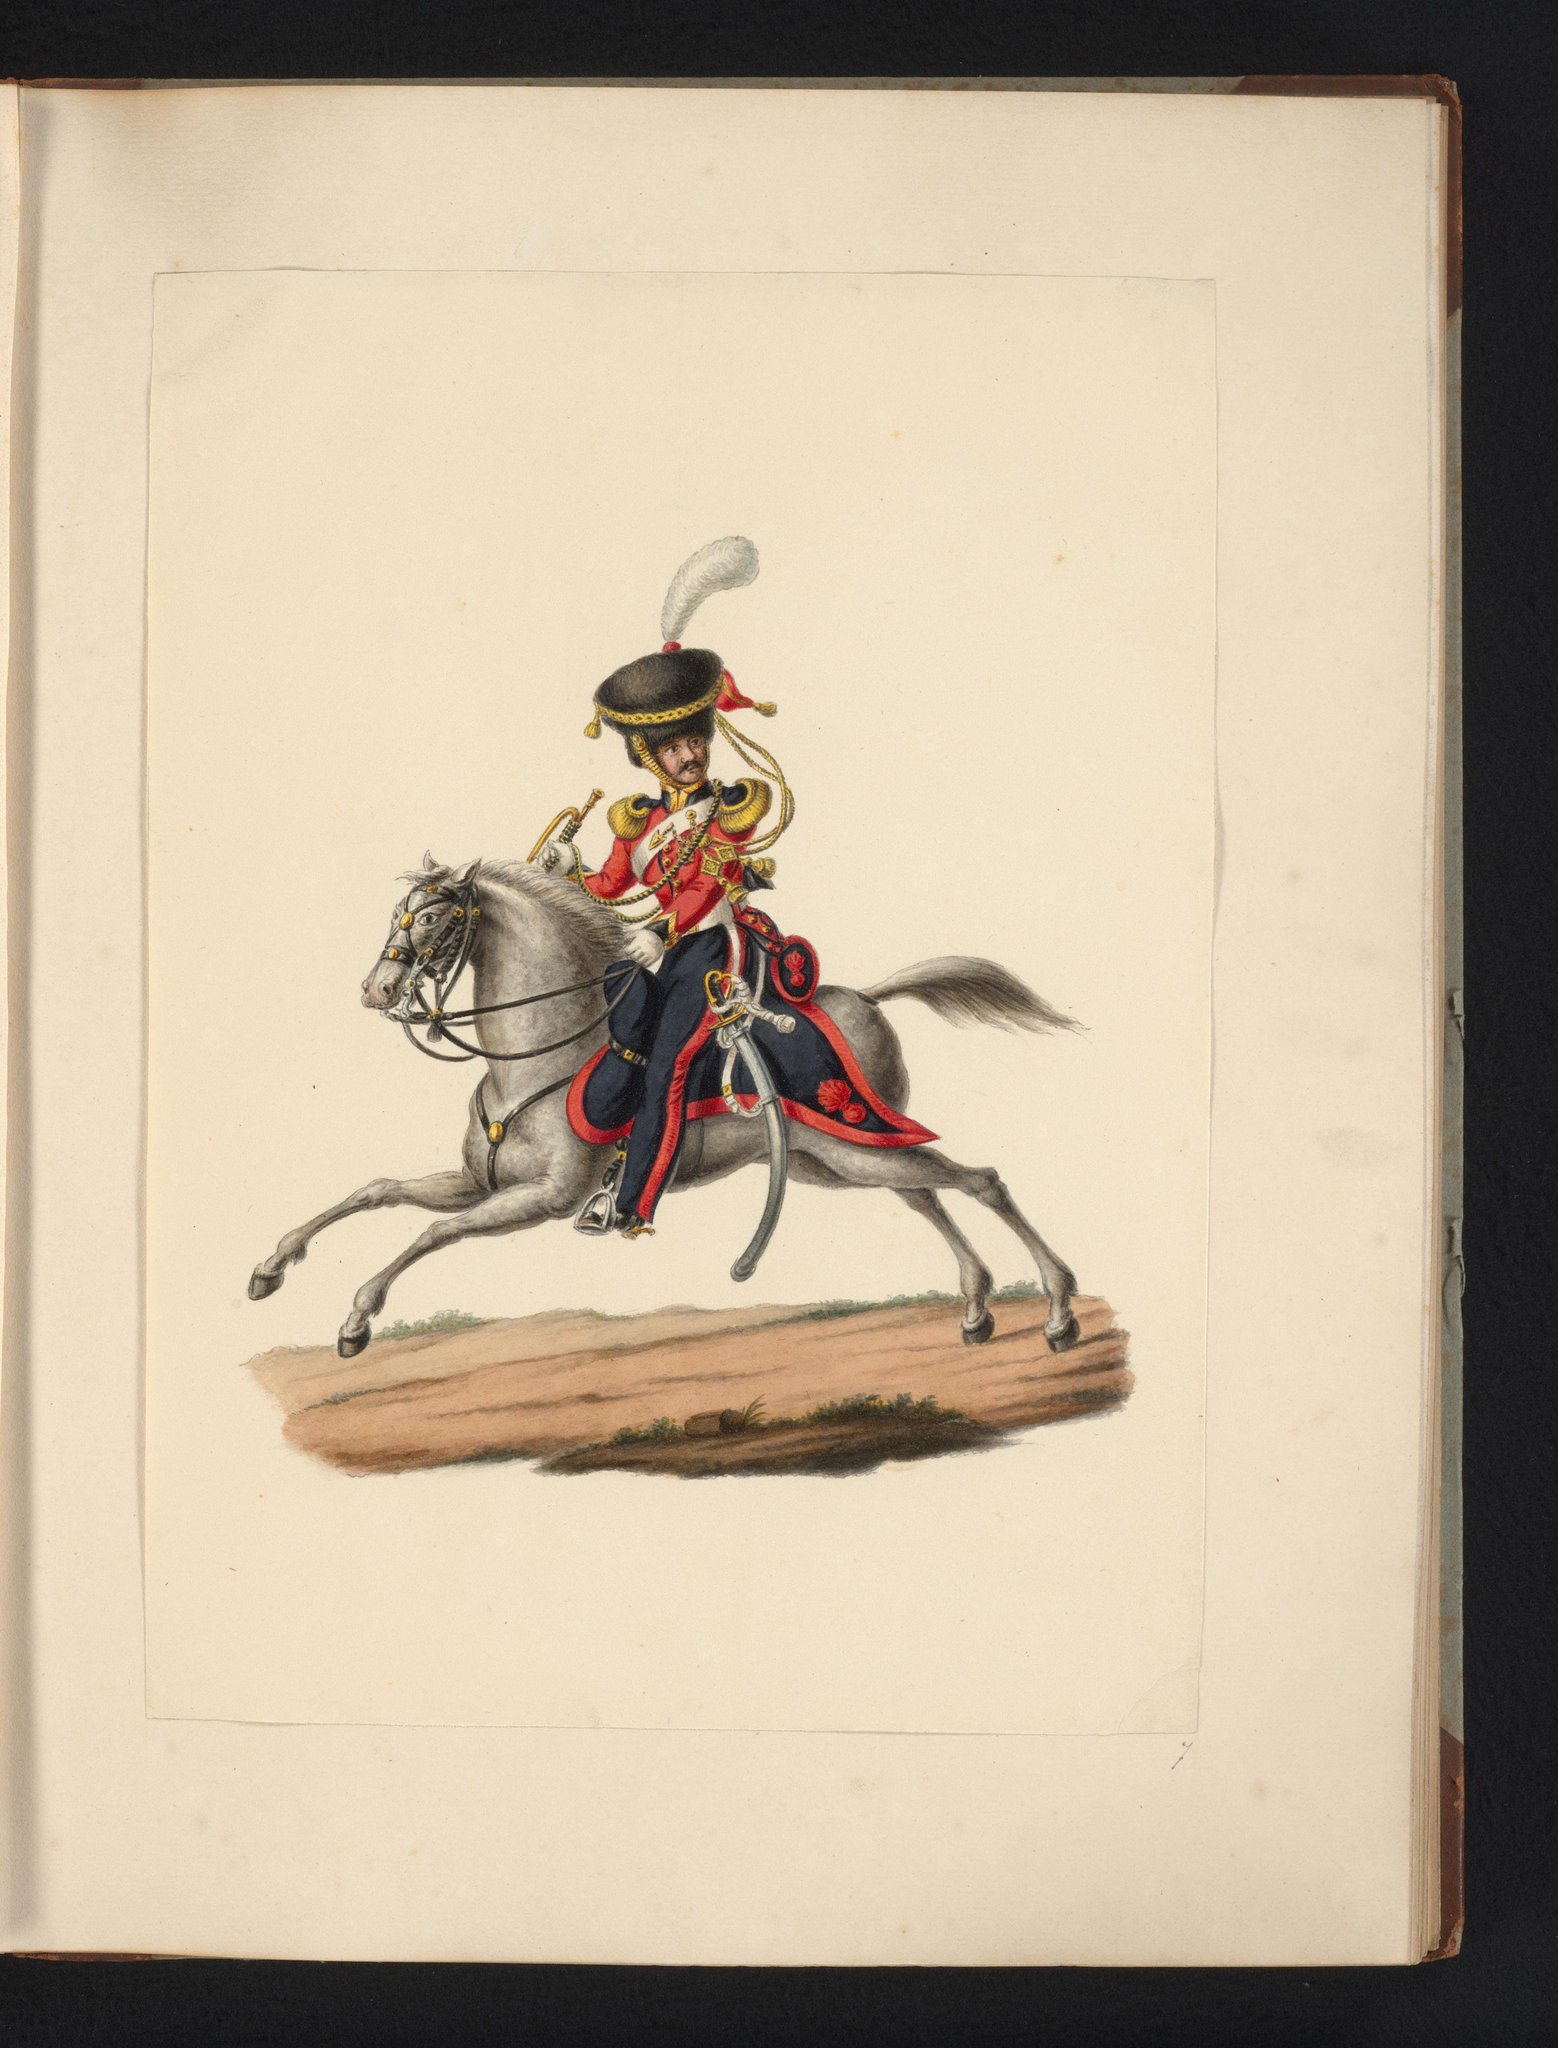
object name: costume print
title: Trompetter van de rijdende artillerie, 1830-1831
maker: Anonymous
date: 1831-1832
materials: paper, pencil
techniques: brush, lacquer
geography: netherlands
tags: professional clothes, (military) uniforms, netherlands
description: Een trompetter van de rijdende artillerie, te paard. Onderdeel van het album met 39 ingeplakte tekeningen van militairen van de Koninklijke Nederlandsche Armee uit 1830-1831.